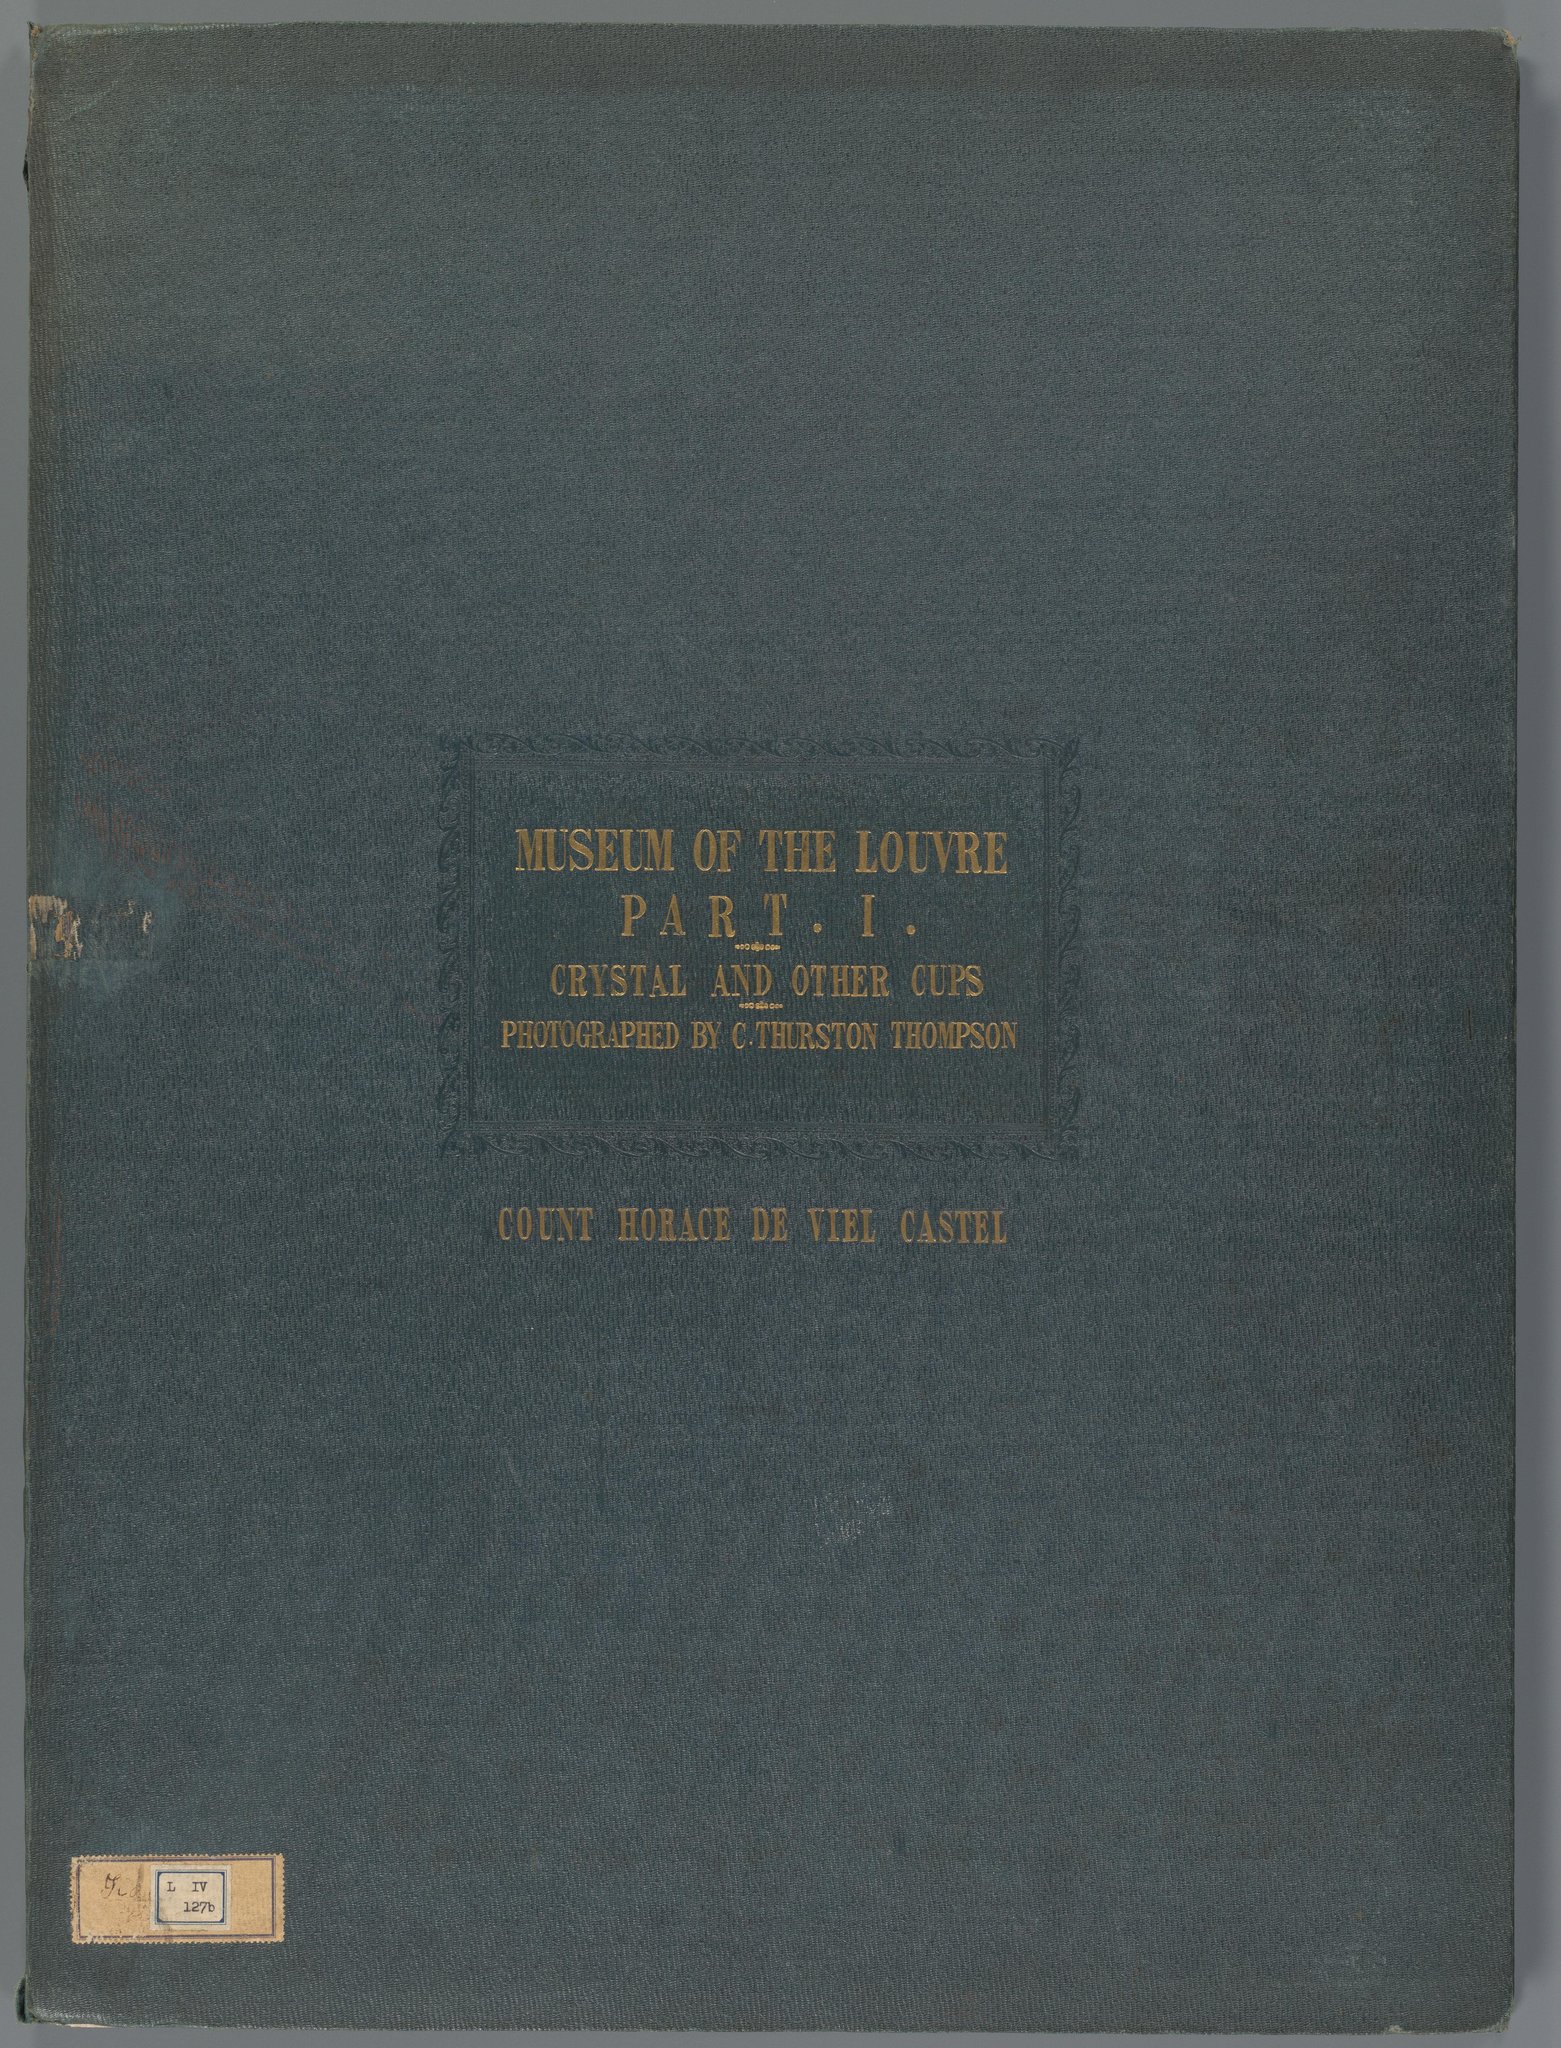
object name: wrapper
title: Omslag voor 32 bladen met fotomechanische afdrukken van kristallen glazen in de collectie van het Louvre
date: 1866-1890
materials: cardboard, textile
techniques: gold embossing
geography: louvre museum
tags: mug, beaker, goblet, container of glass: bottle, jar, vase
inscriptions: inscription: ‘Hartkamp’, label: ‘L IV/ 127b’